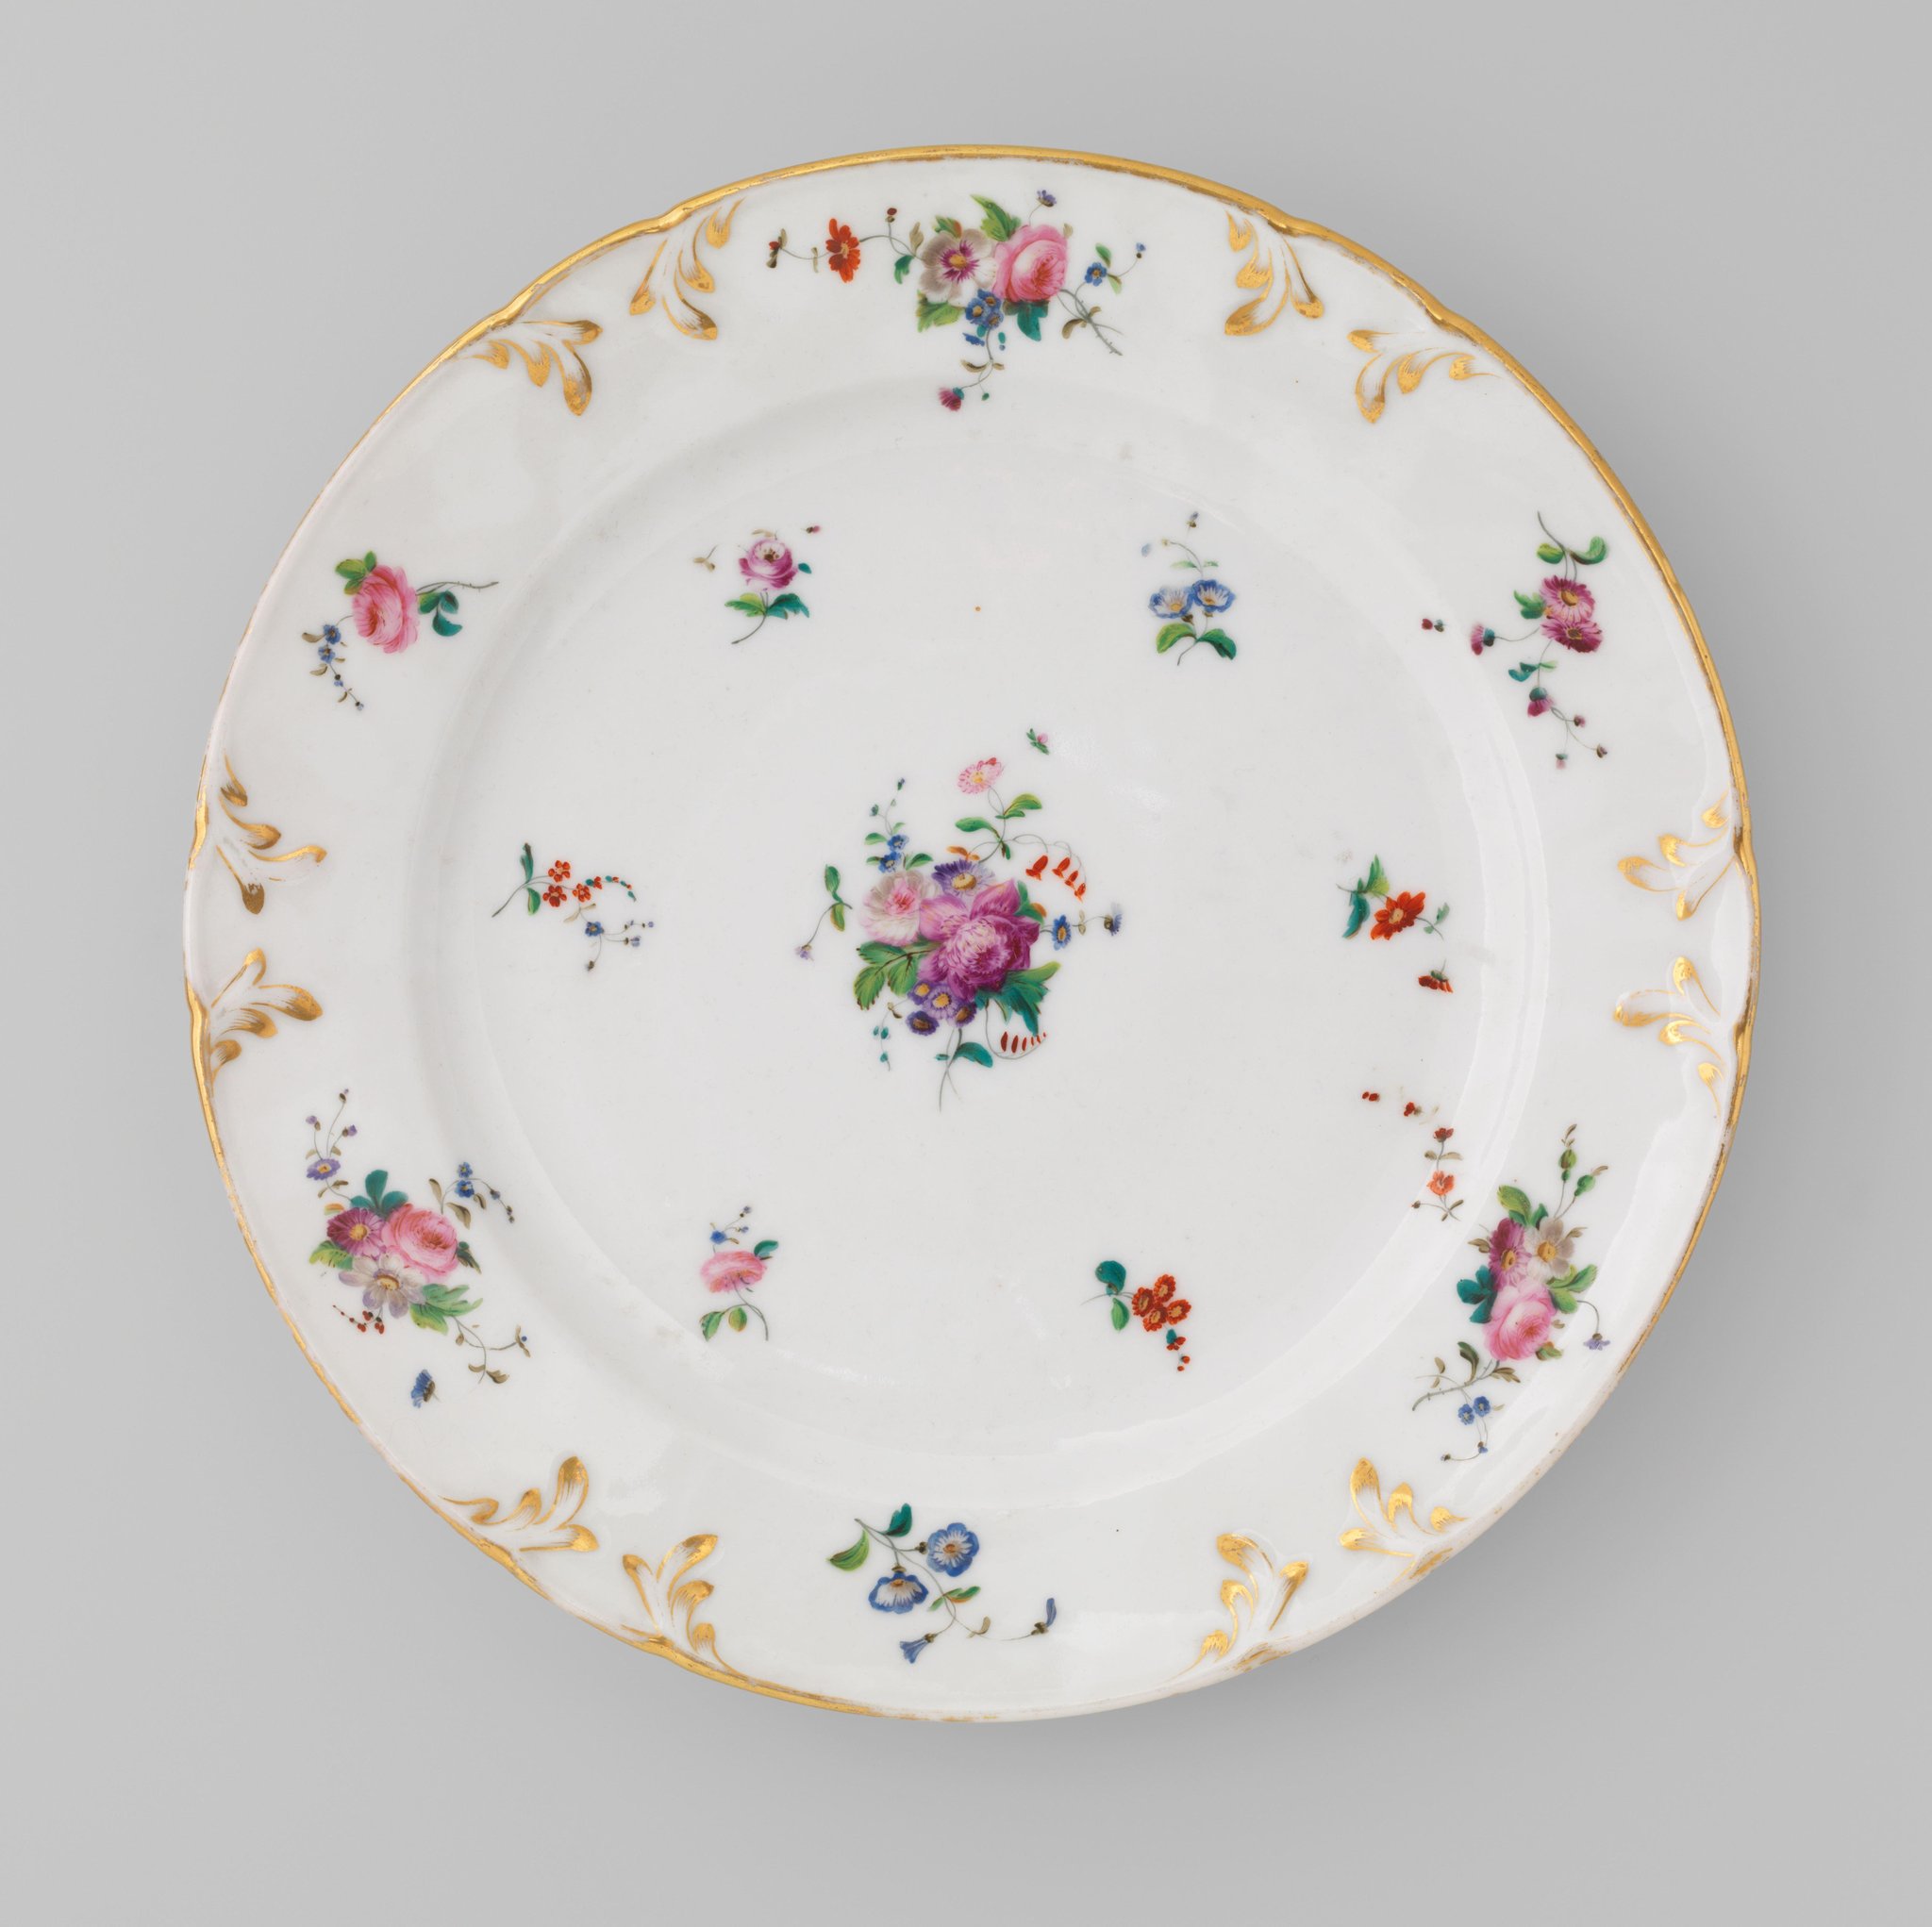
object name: service set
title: Dish with bouquets and flower sprays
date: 1839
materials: glaze, gold, paint, porcelain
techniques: firing, forming, gilding, turning, vitrification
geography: paris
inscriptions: mark: ‘DENUELLE/ Boulevard St. Denis 18/ à Paris’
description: Schotel van porselein met een gelobde rand, beschilderd op het glazuur in blauw, rood, roze, groen, geel, paars, zwart en goud. Op het plat boeketten van verschillende bloemen en strooibloemen. Vanuit de gelobde, gouden rand, gemodelleerde bladranken in reliëf, aangezet met goud. Hiertussen boeketten. Dubbele voetring. Gemerkt op de onderzijde met 'DENUELLE/ Boulevard St. Denis 18/ à Paris'.